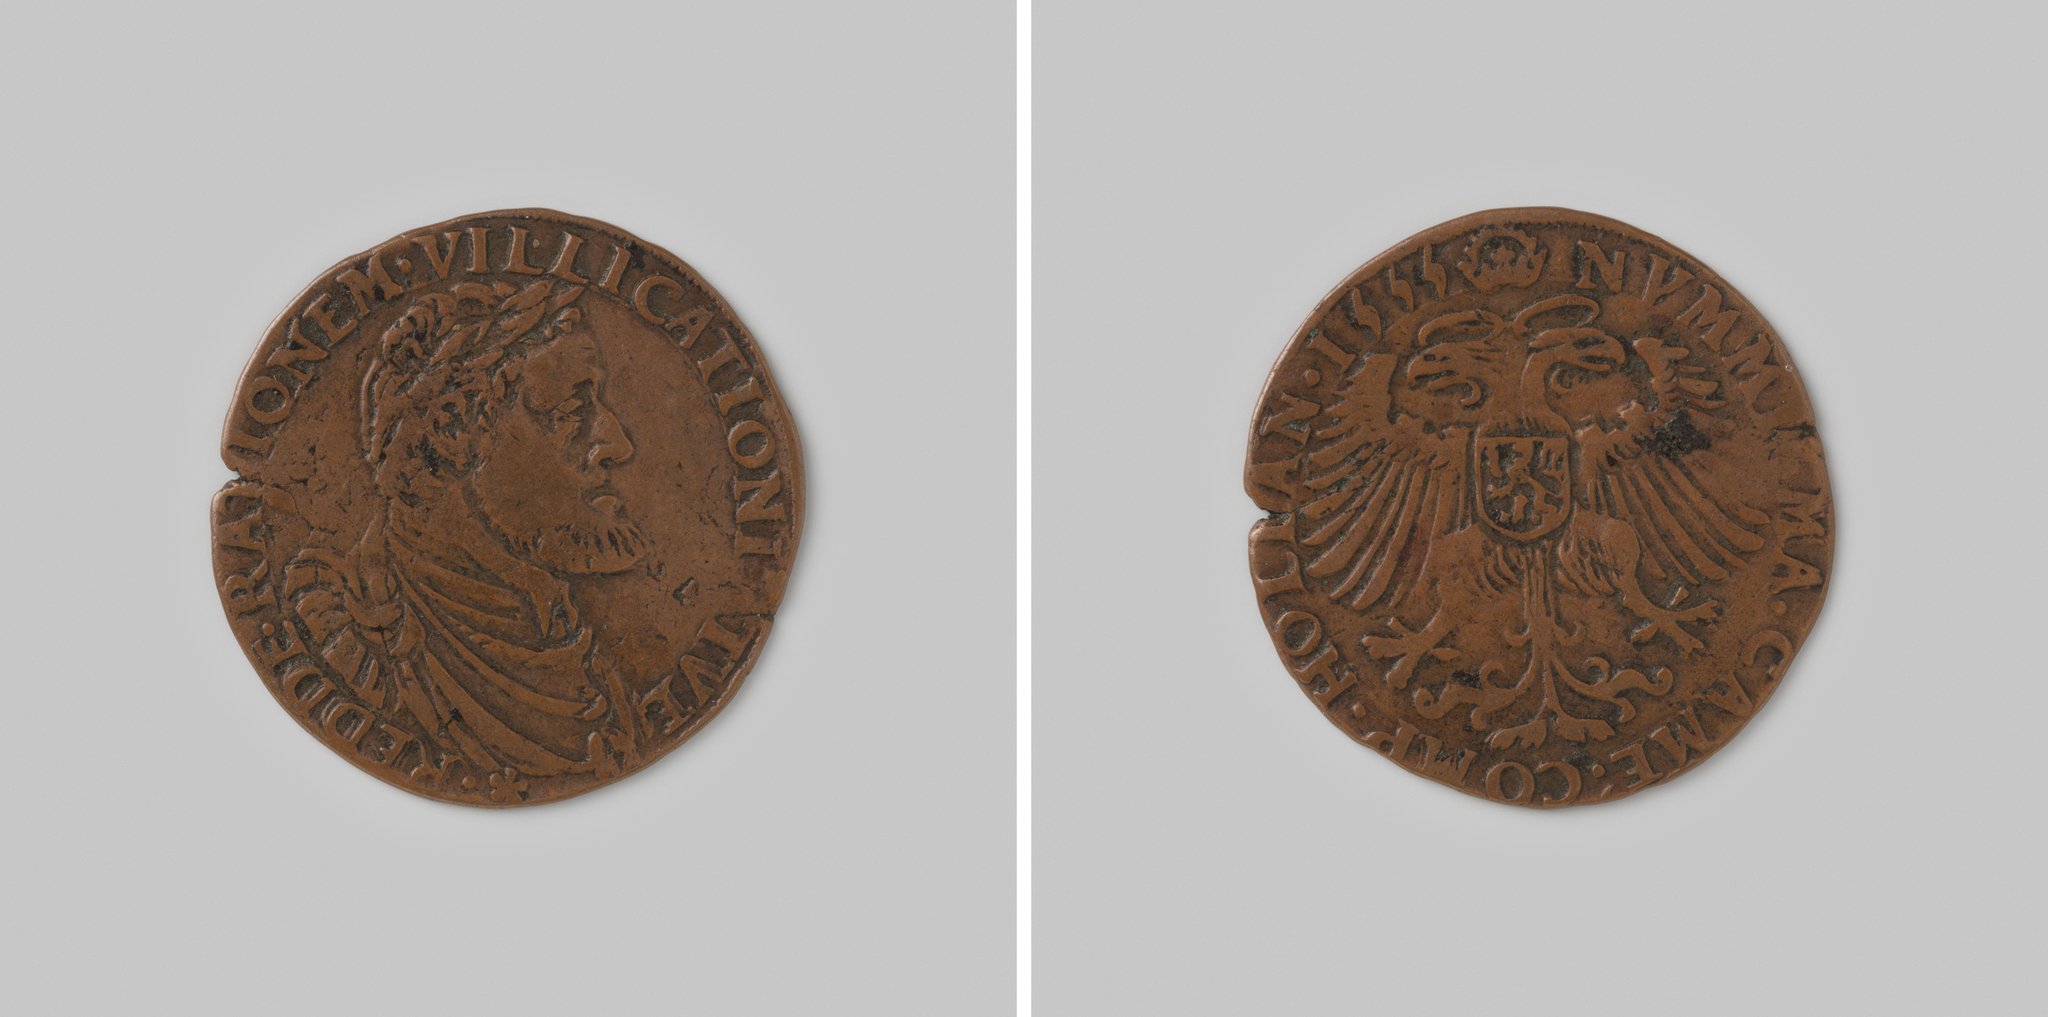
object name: jeton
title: Rekenpenning uit Dordrecht voor de Rekenkamer van Holland op het aftreden van Karel V 1555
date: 1555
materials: copper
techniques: striking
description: Koperen penning, op de voorzijde het borstbeeld van Karel V naar rechts met omschrift, op de keerzijde een gekroonde dubbelkoppige adelaar met hartschild Holland, met omschrift.